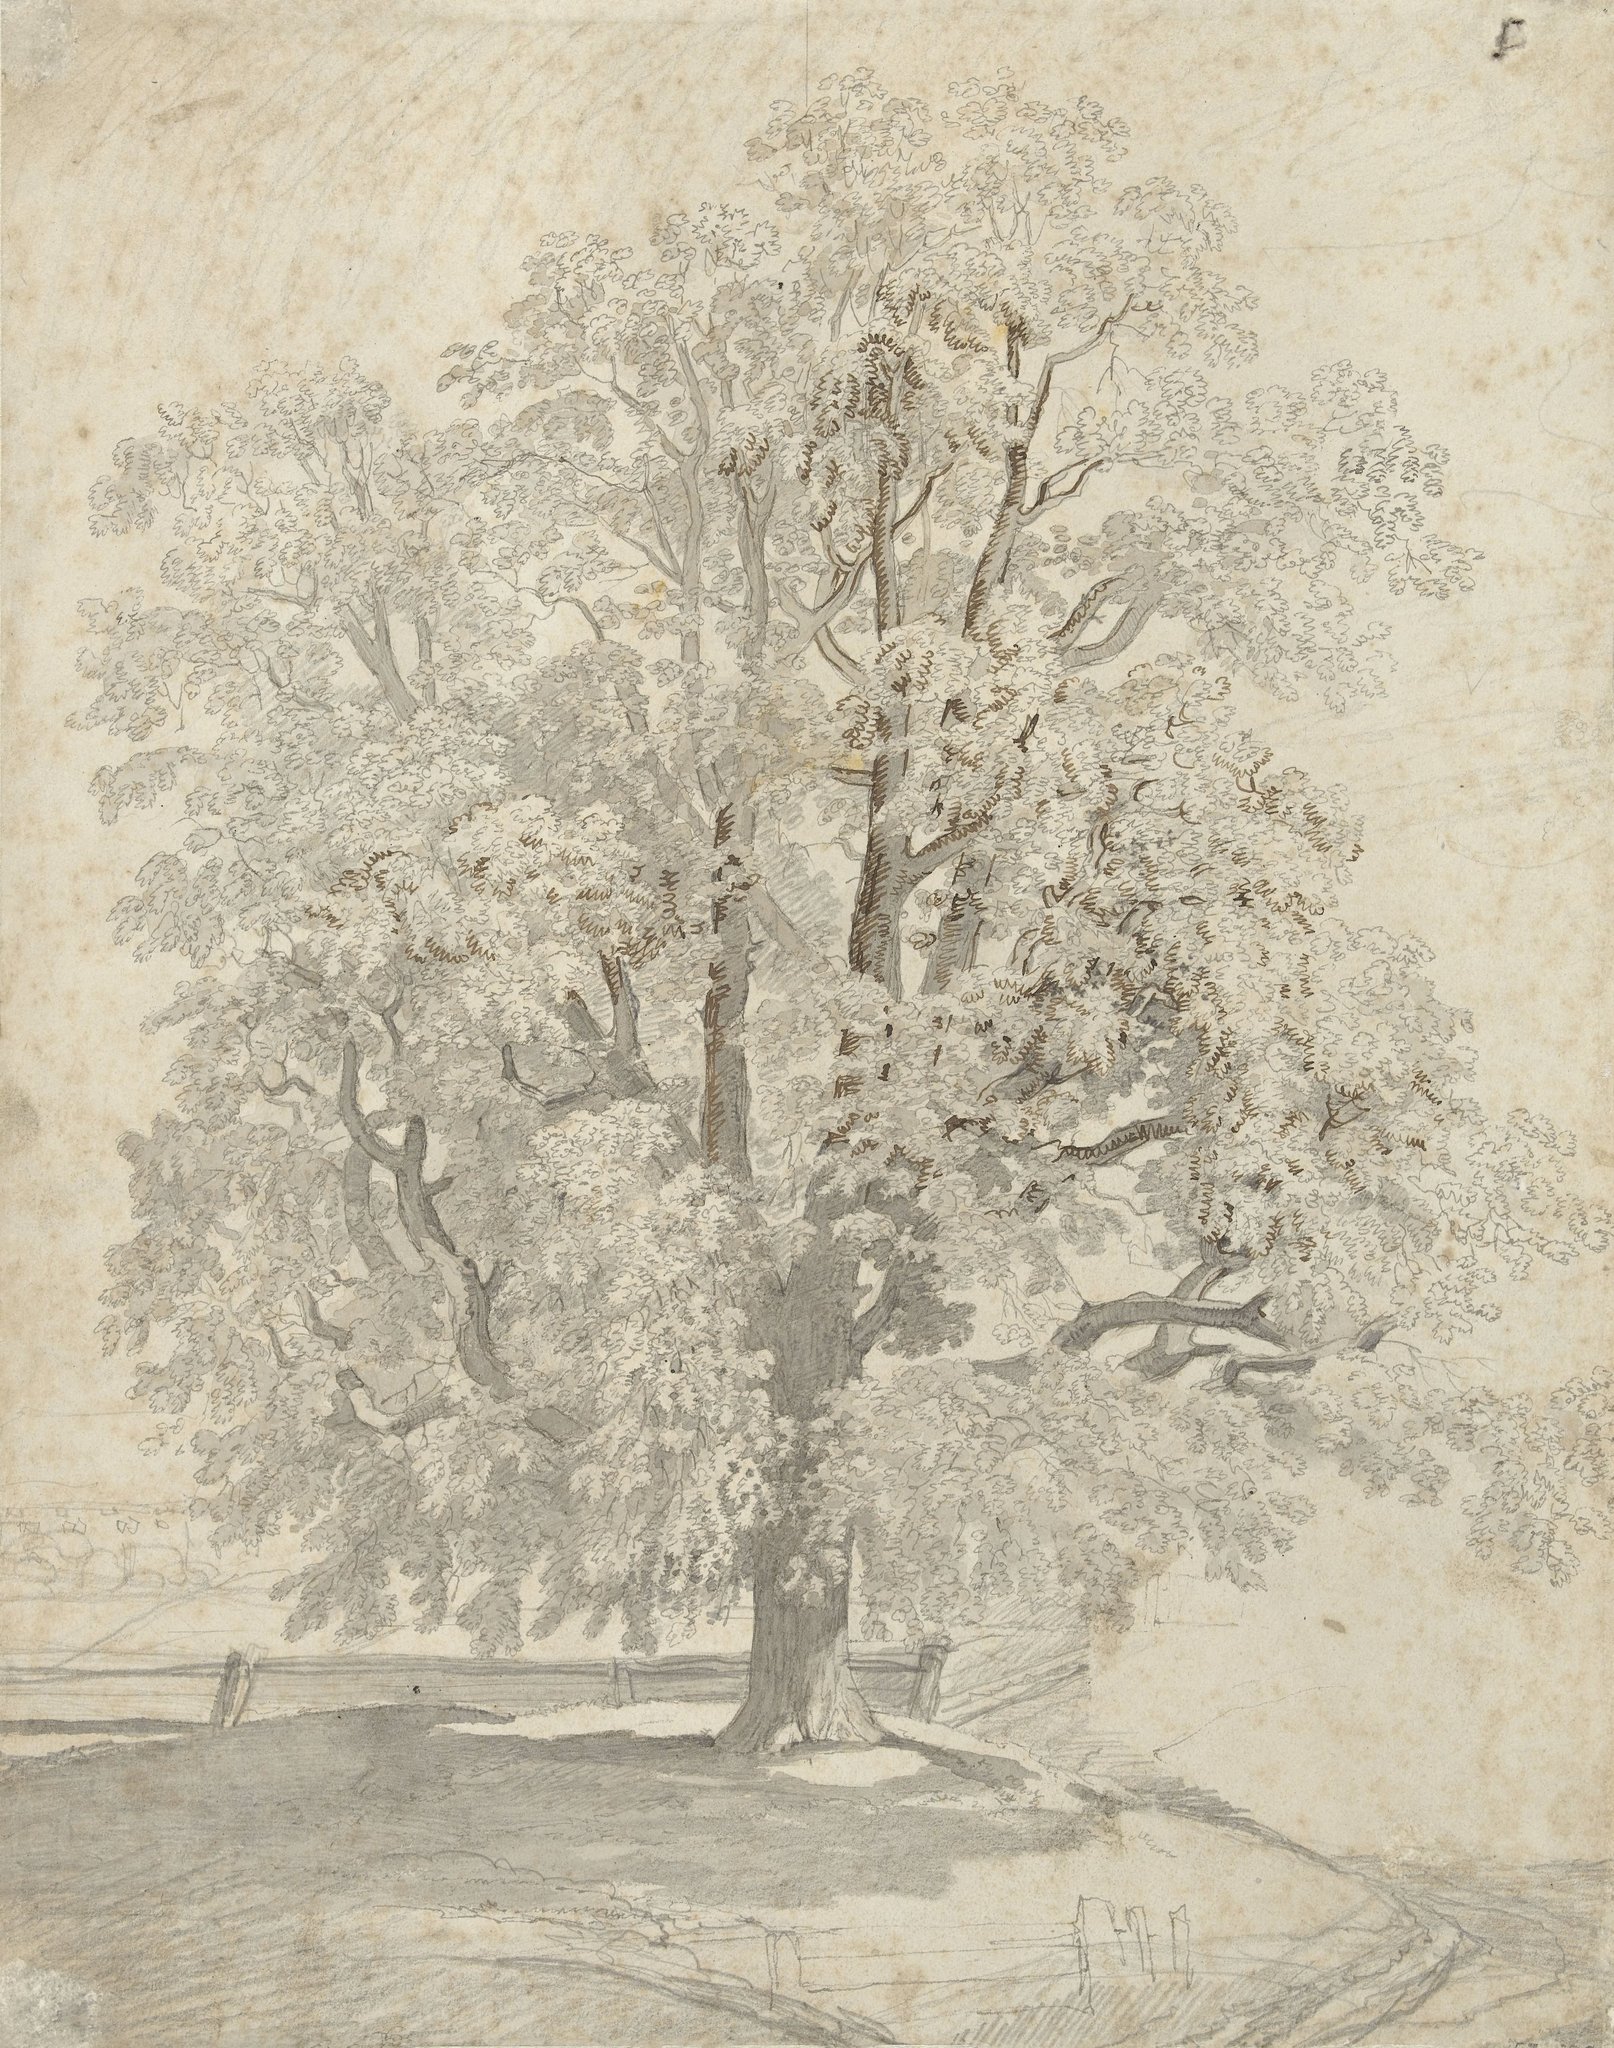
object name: drawing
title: Boomstudie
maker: franz edmund weirotter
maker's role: draughtsman, painter, print maker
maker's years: 1733-1771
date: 1740-1771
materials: ink, paper, pencil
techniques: brush, pen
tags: trees